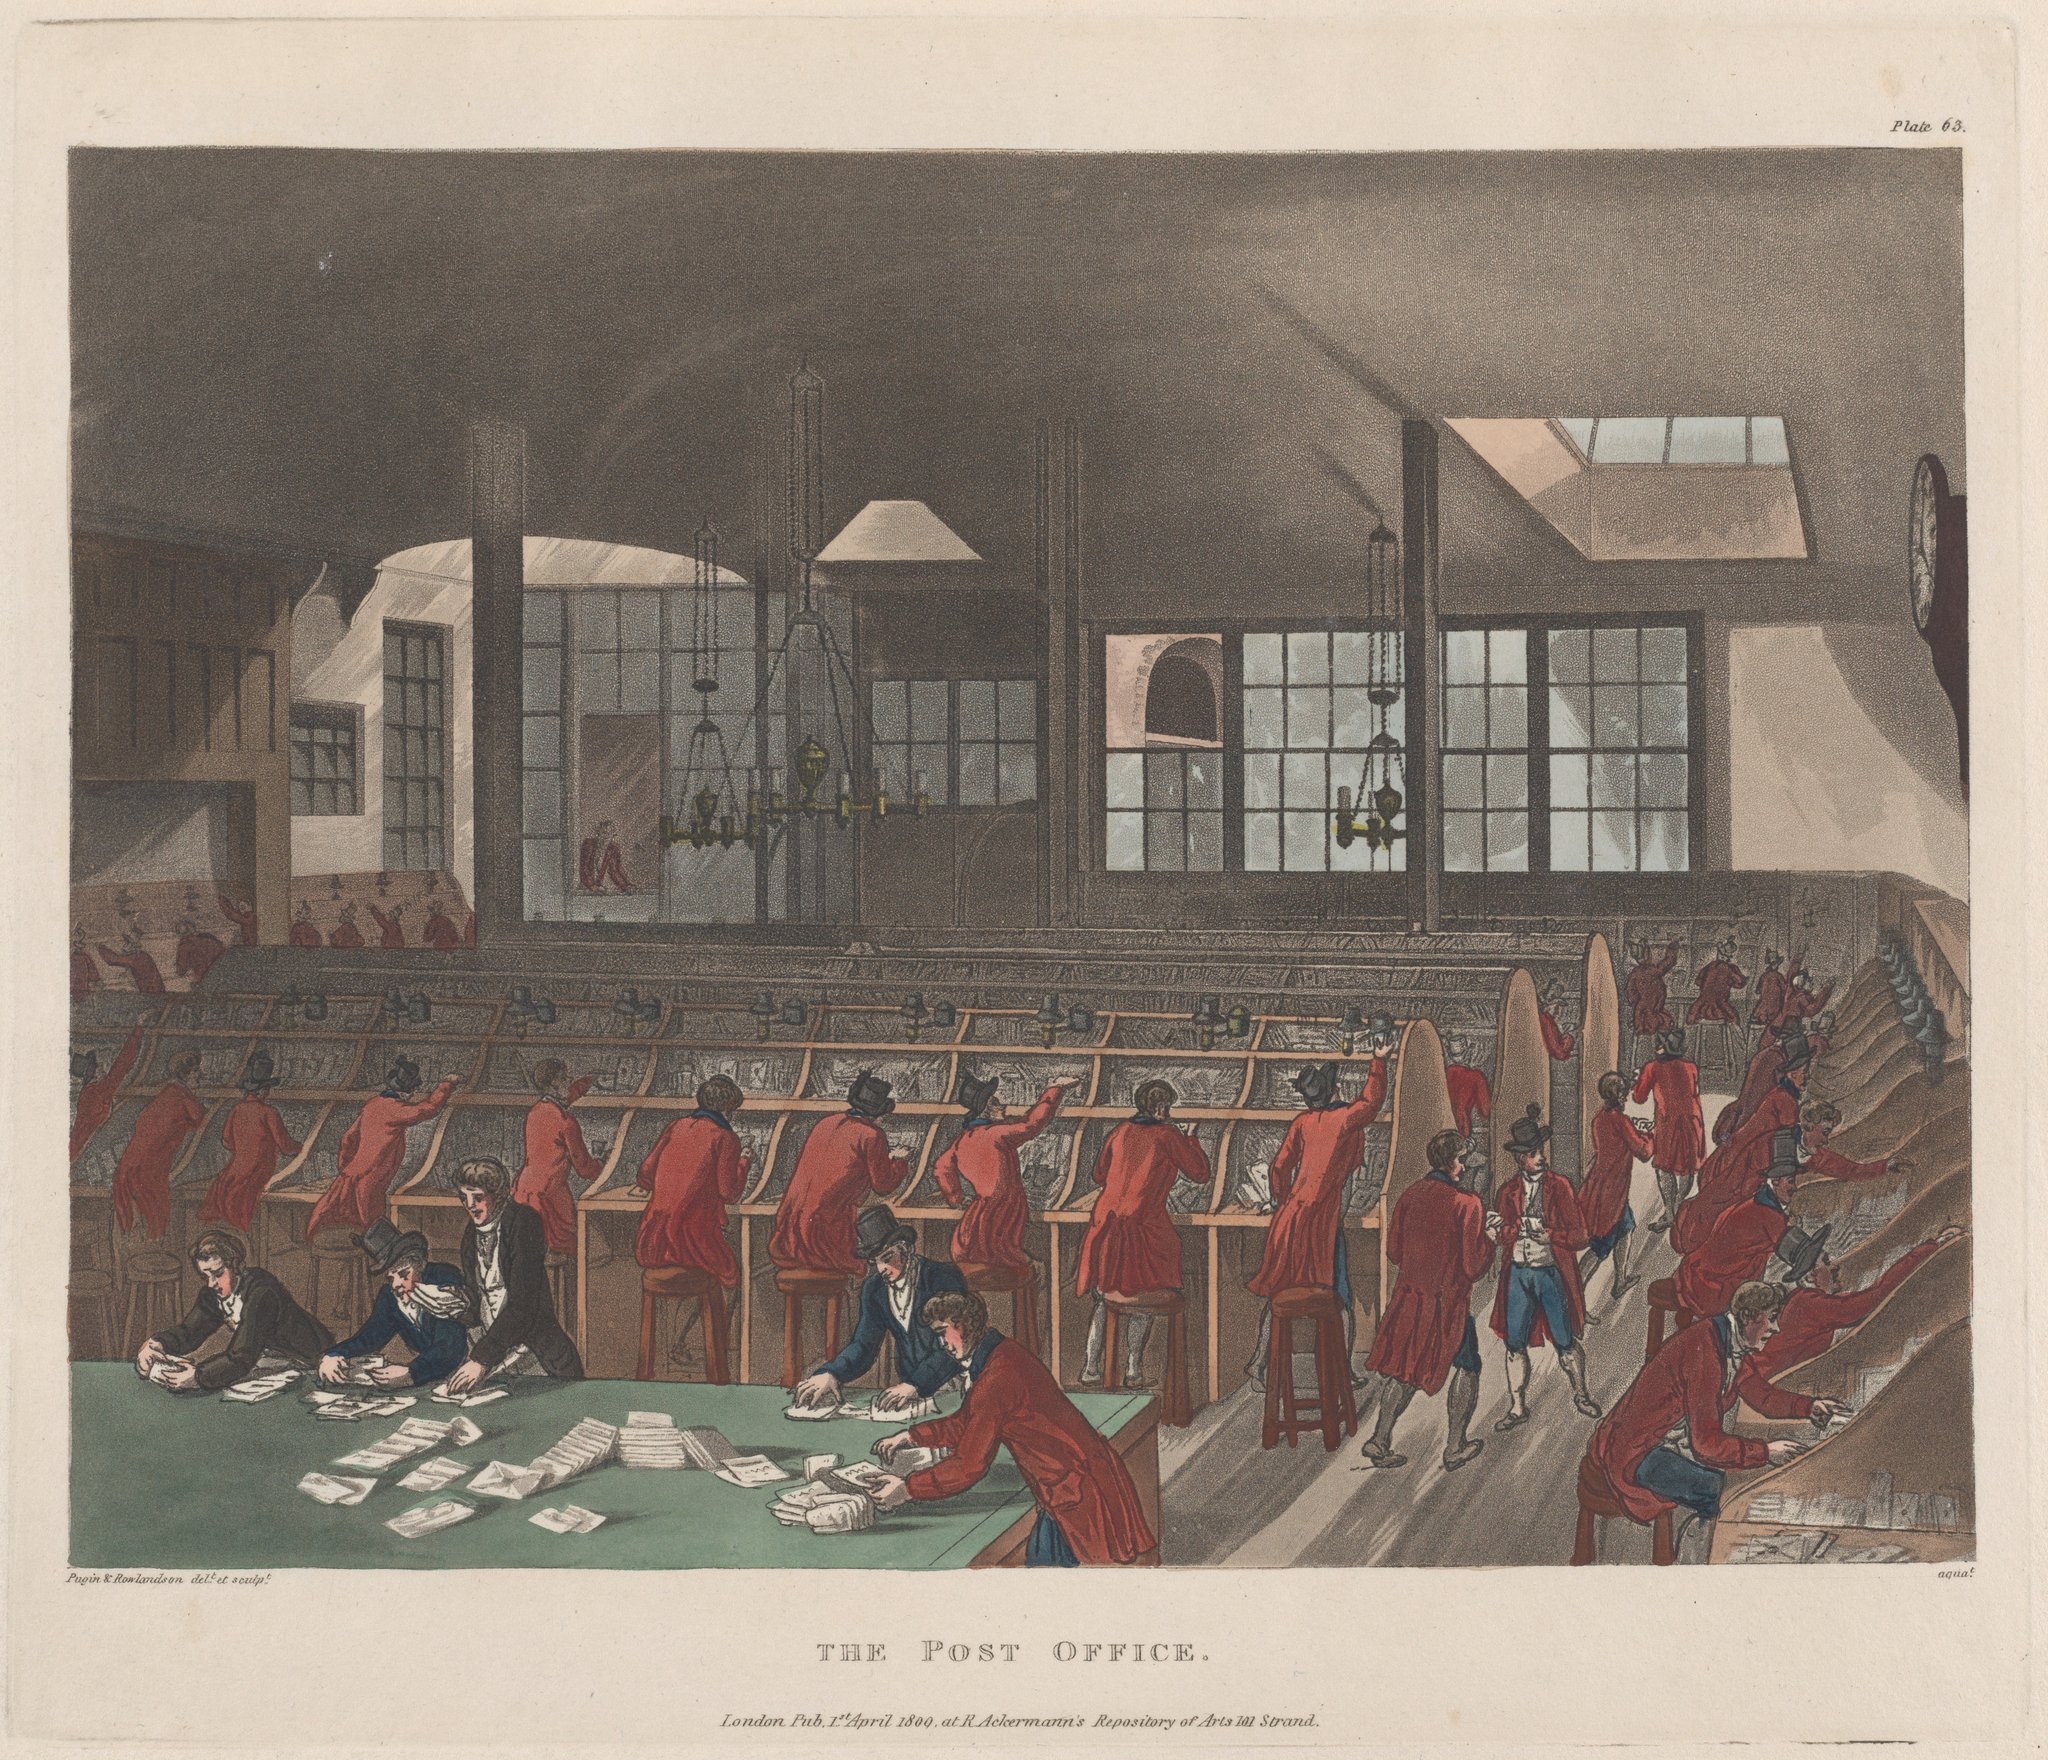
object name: print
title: The Post Office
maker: thomas rowlandson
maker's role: artist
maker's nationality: british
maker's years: 1757-1827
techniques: aquatint, etching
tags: post offices,interiors,men,working